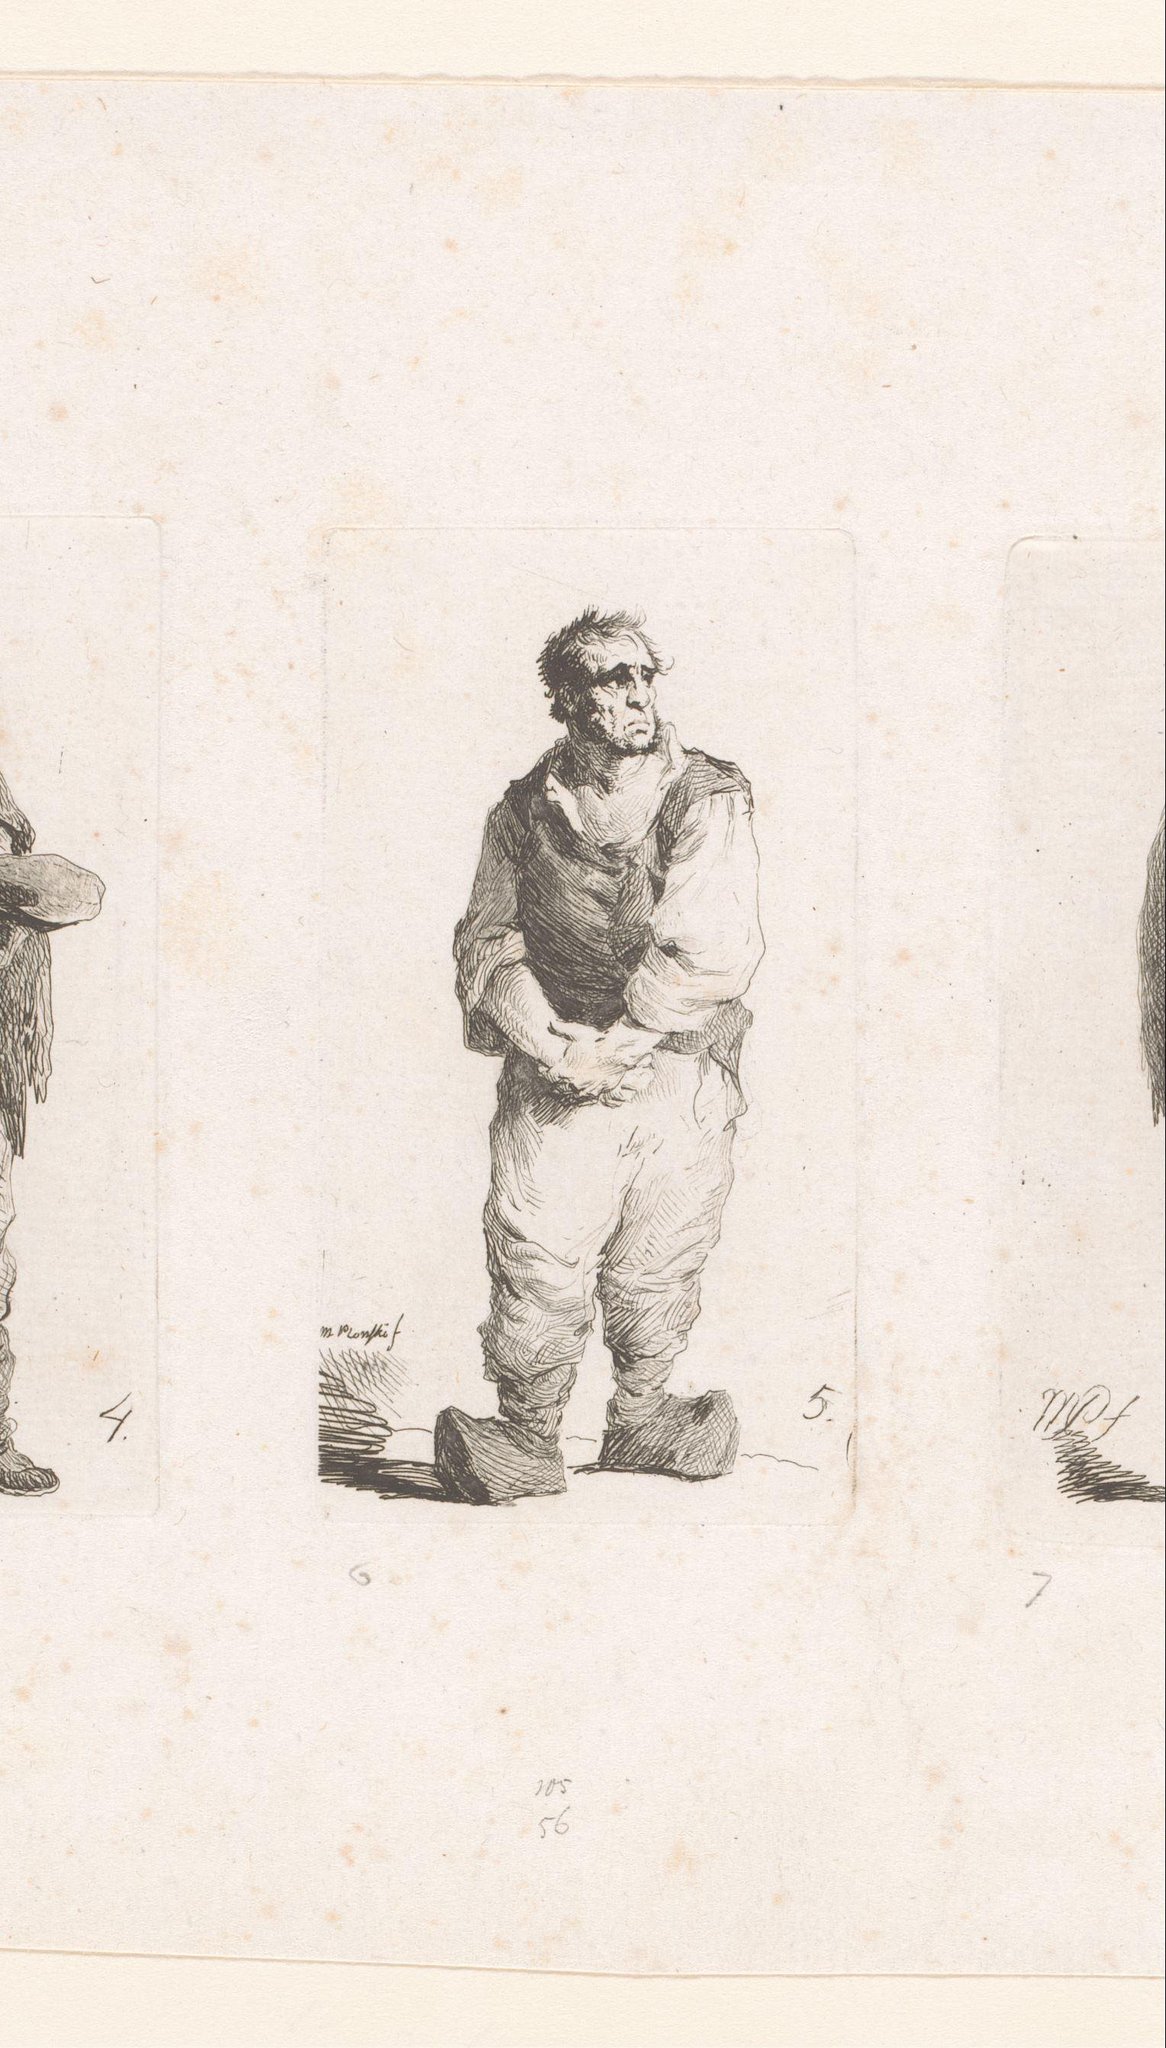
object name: print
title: Veertien etsen van Michał Płoński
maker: michał płoński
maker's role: print maker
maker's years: 1778-1812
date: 1802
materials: paper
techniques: etching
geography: amsterdam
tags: farmers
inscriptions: collector's mark: Lugt 2228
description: Op één blad met RP-P-1885-A-8761 en RP-P-1885-A-8763.